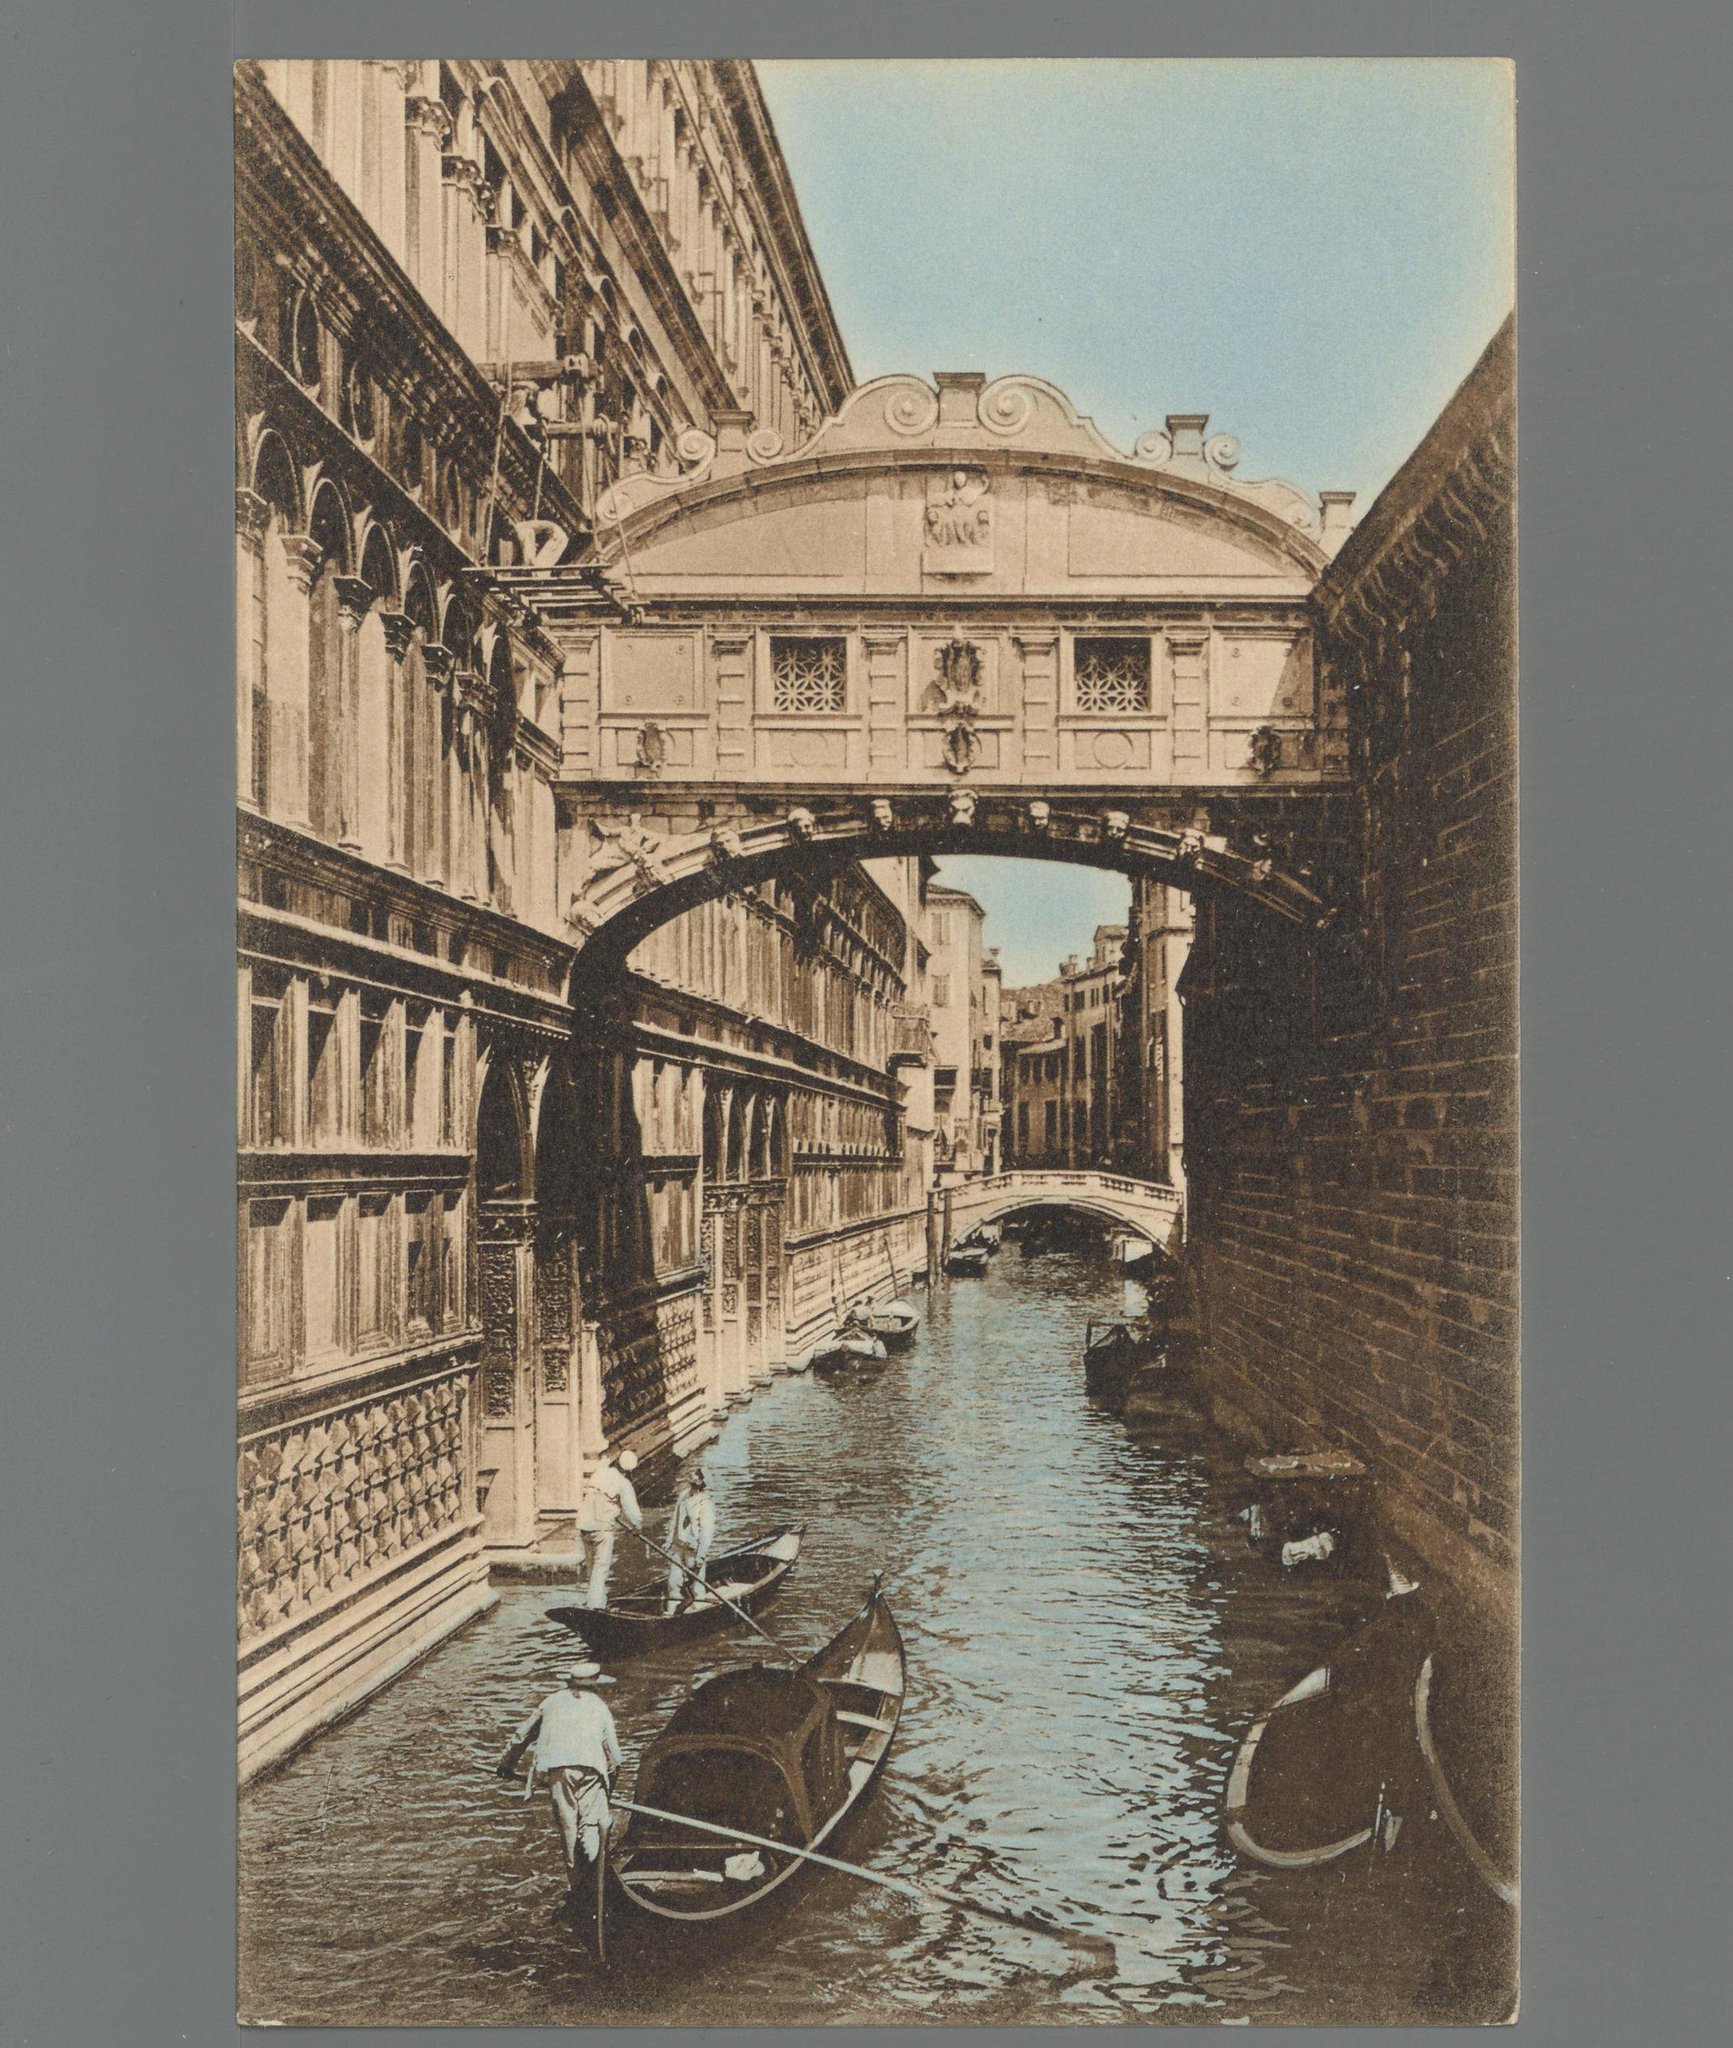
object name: photomechanical print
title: Venezia. Ponte dei Sospiri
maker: Anonymous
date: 1906-1920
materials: cardboard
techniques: photograph, lithograph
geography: venice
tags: river, bridge in city across river, canal, etc., city-view, and landscape with man-made constructions (+ city(-scape) with figures, staffage)